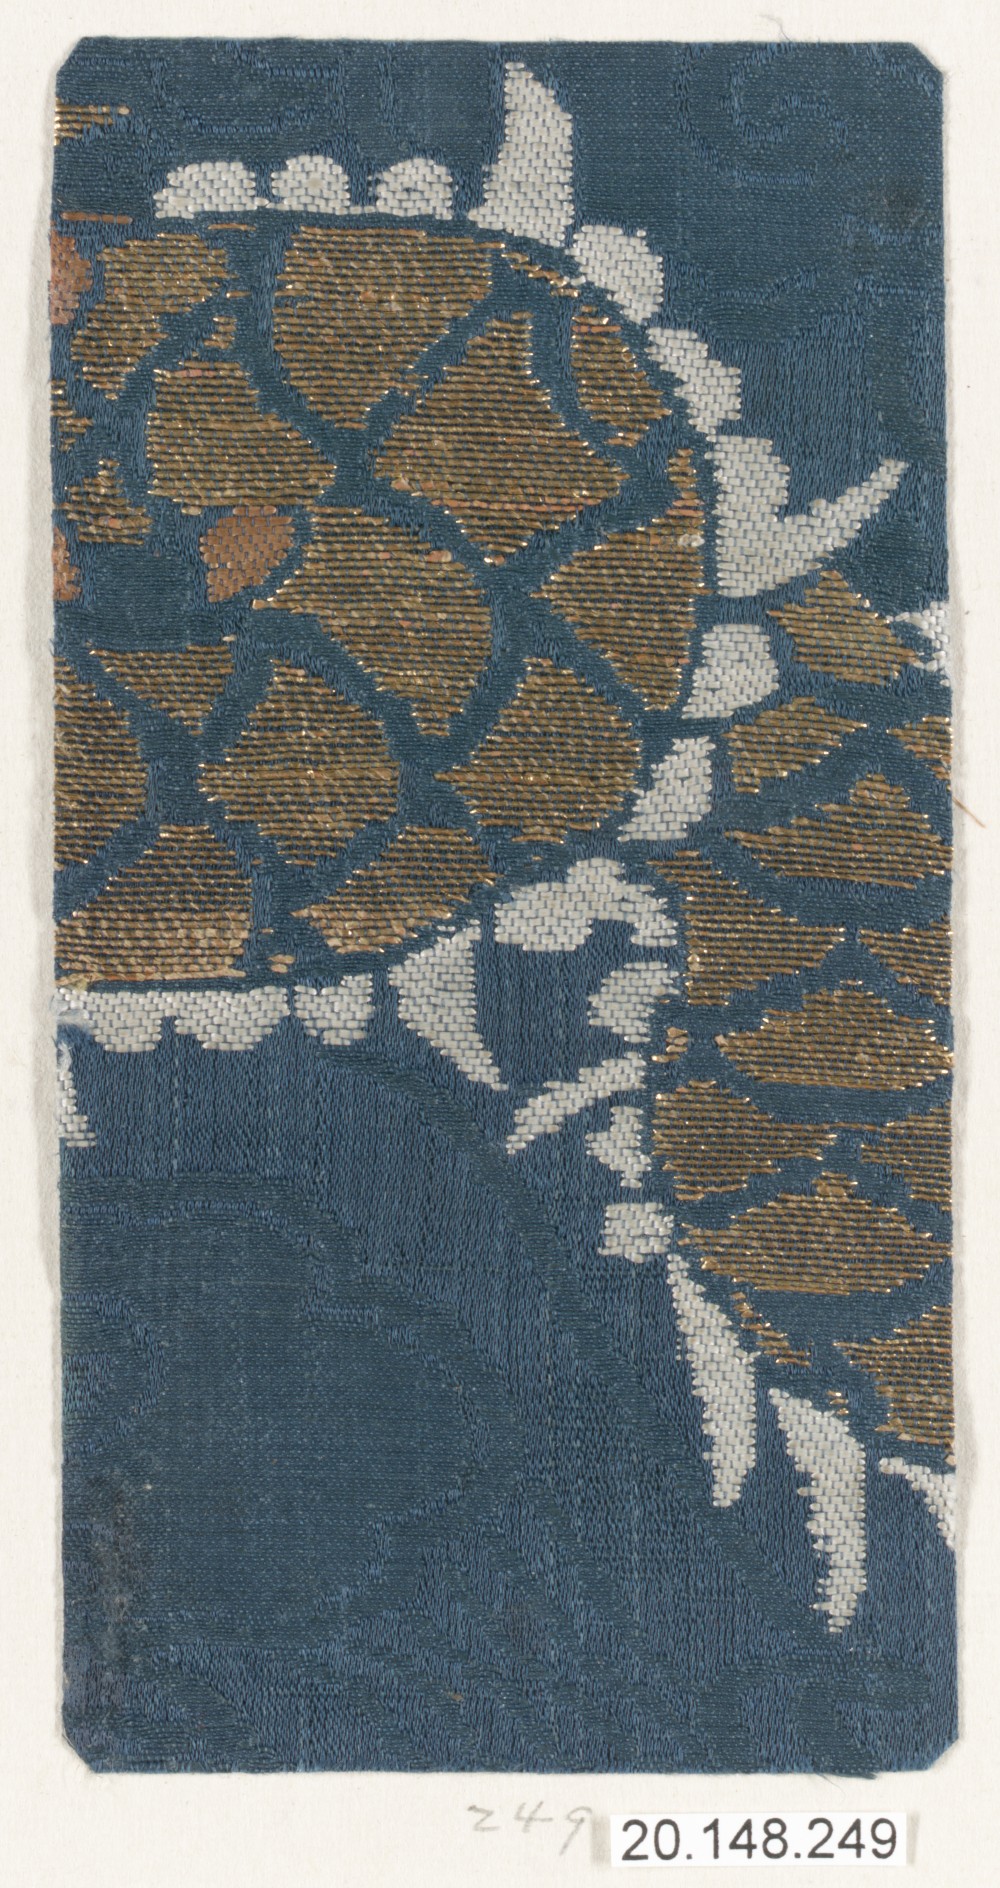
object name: piece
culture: japanese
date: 1601-1700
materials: silk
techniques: compound weave